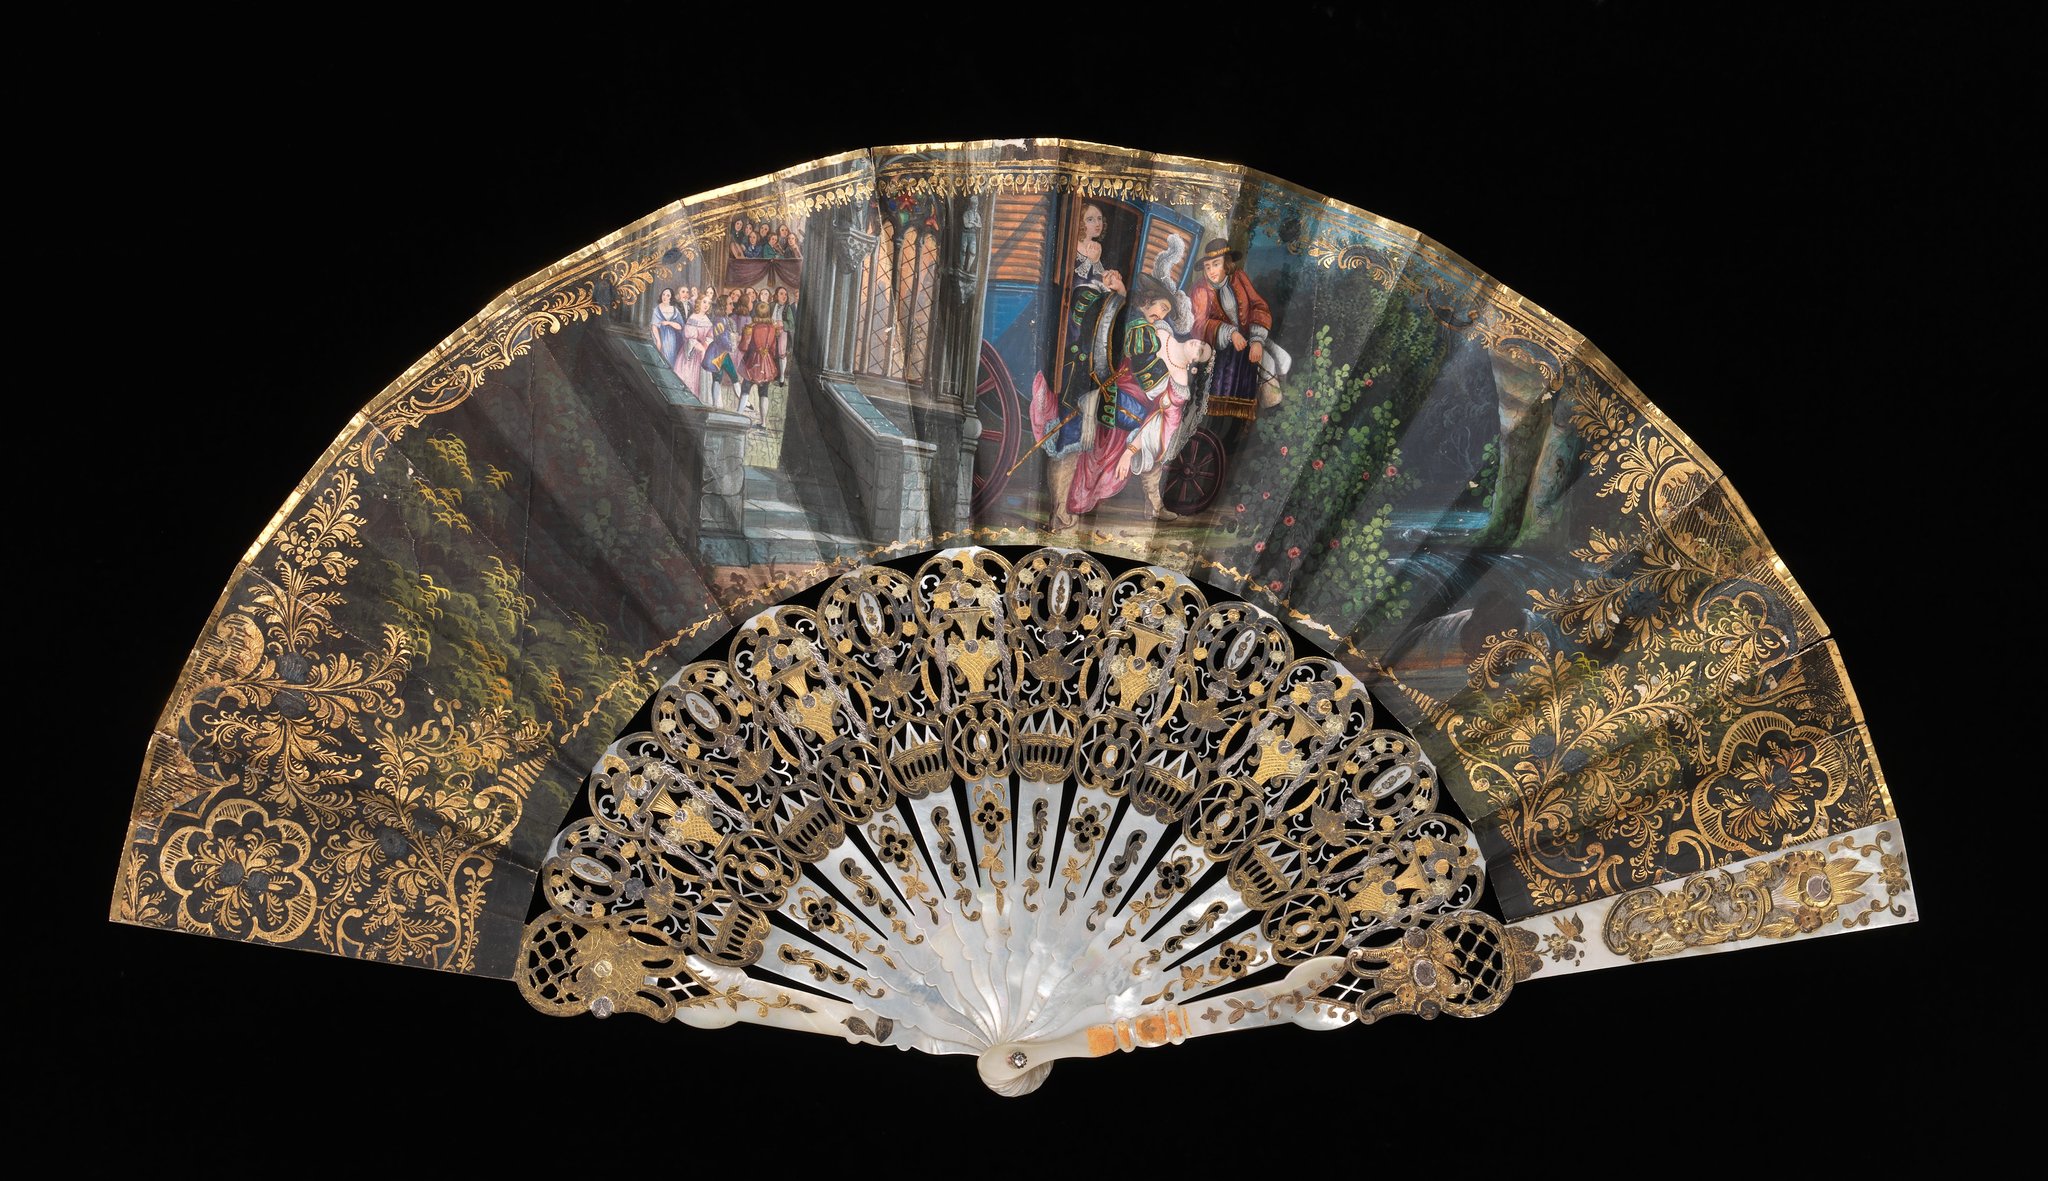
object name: fan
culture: european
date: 1860-1869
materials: gouache, metal, mother of pearl, paper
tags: men,women,carriages